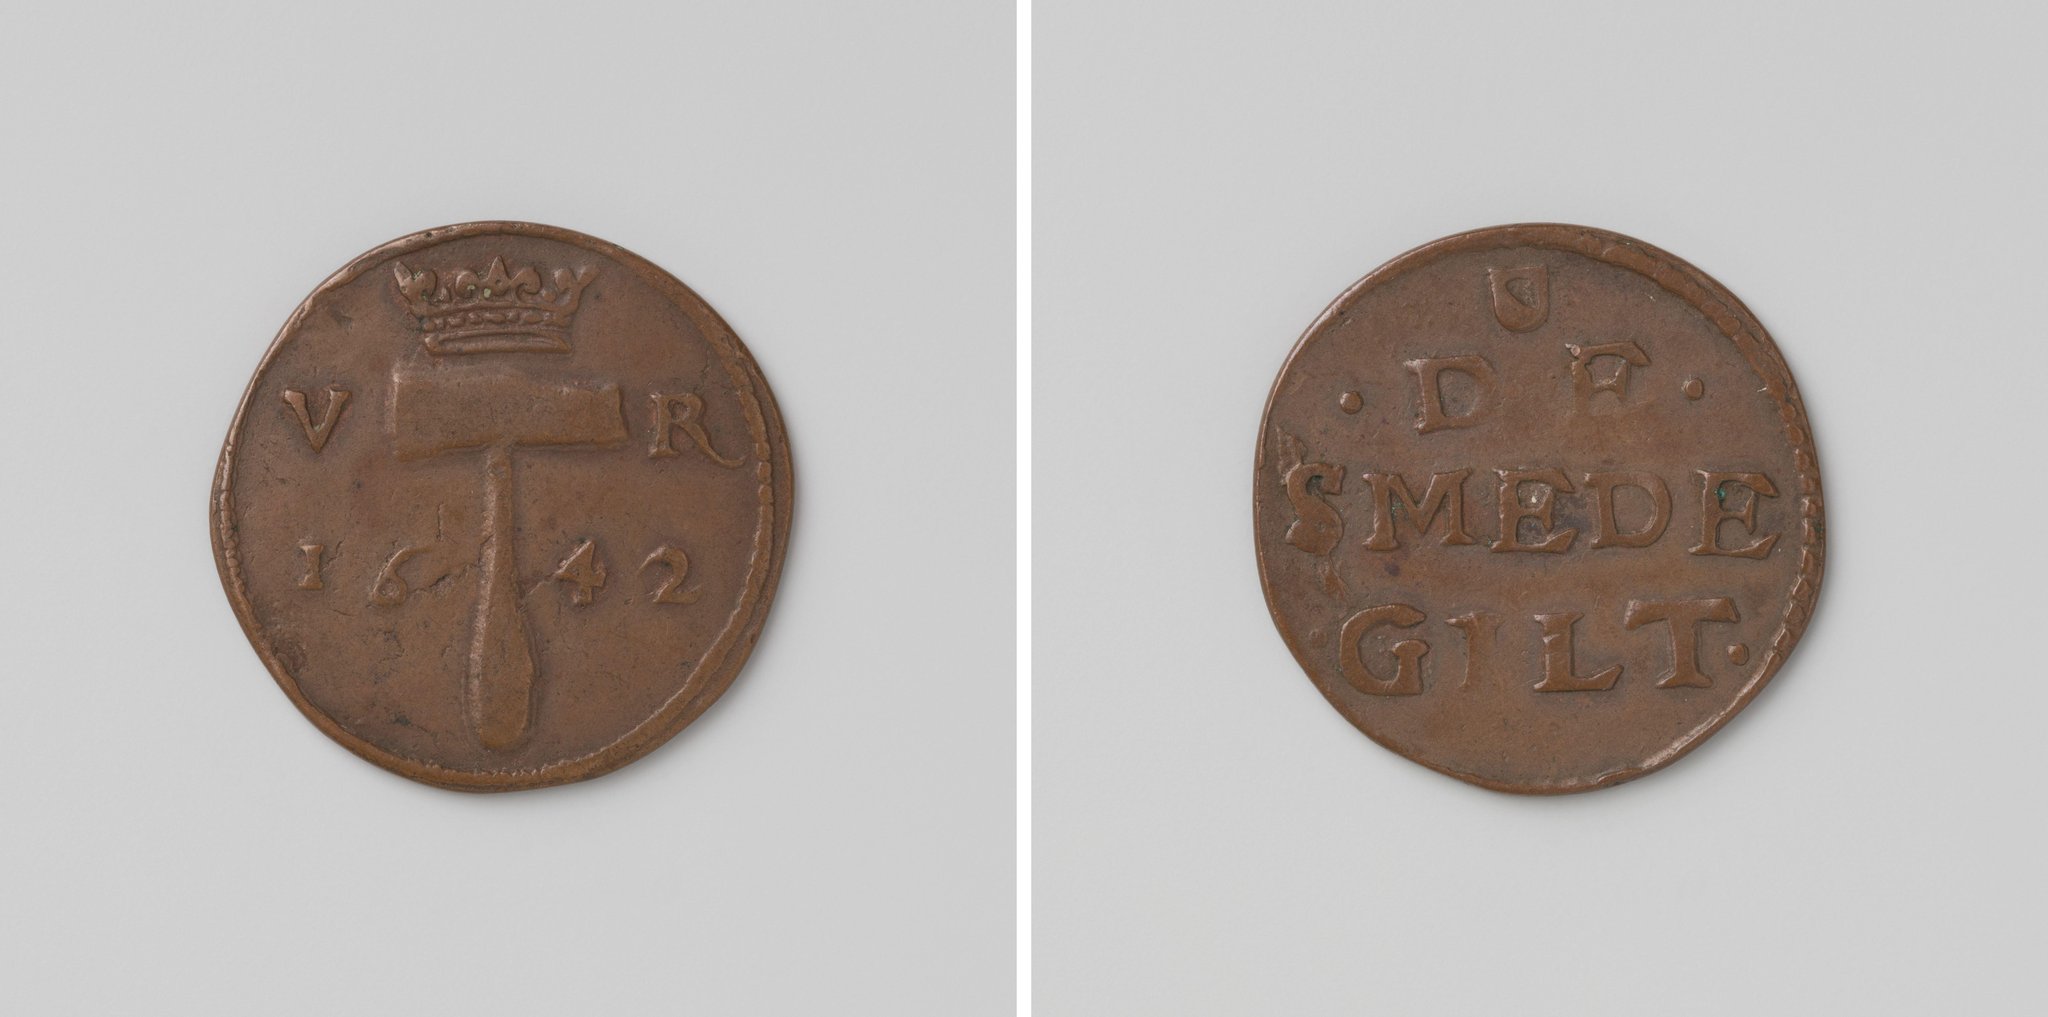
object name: medal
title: Gildepenning van het Smedengilde te Utrecht.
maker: Anonymous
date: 1642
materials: copper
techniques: striking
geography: utrecht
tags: utrecht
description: Koperen penning. Voorzijde: gekroonde voorslaghamer tussen letters V en R en jaartal. Keerzijde: opschrift onder wapenschild